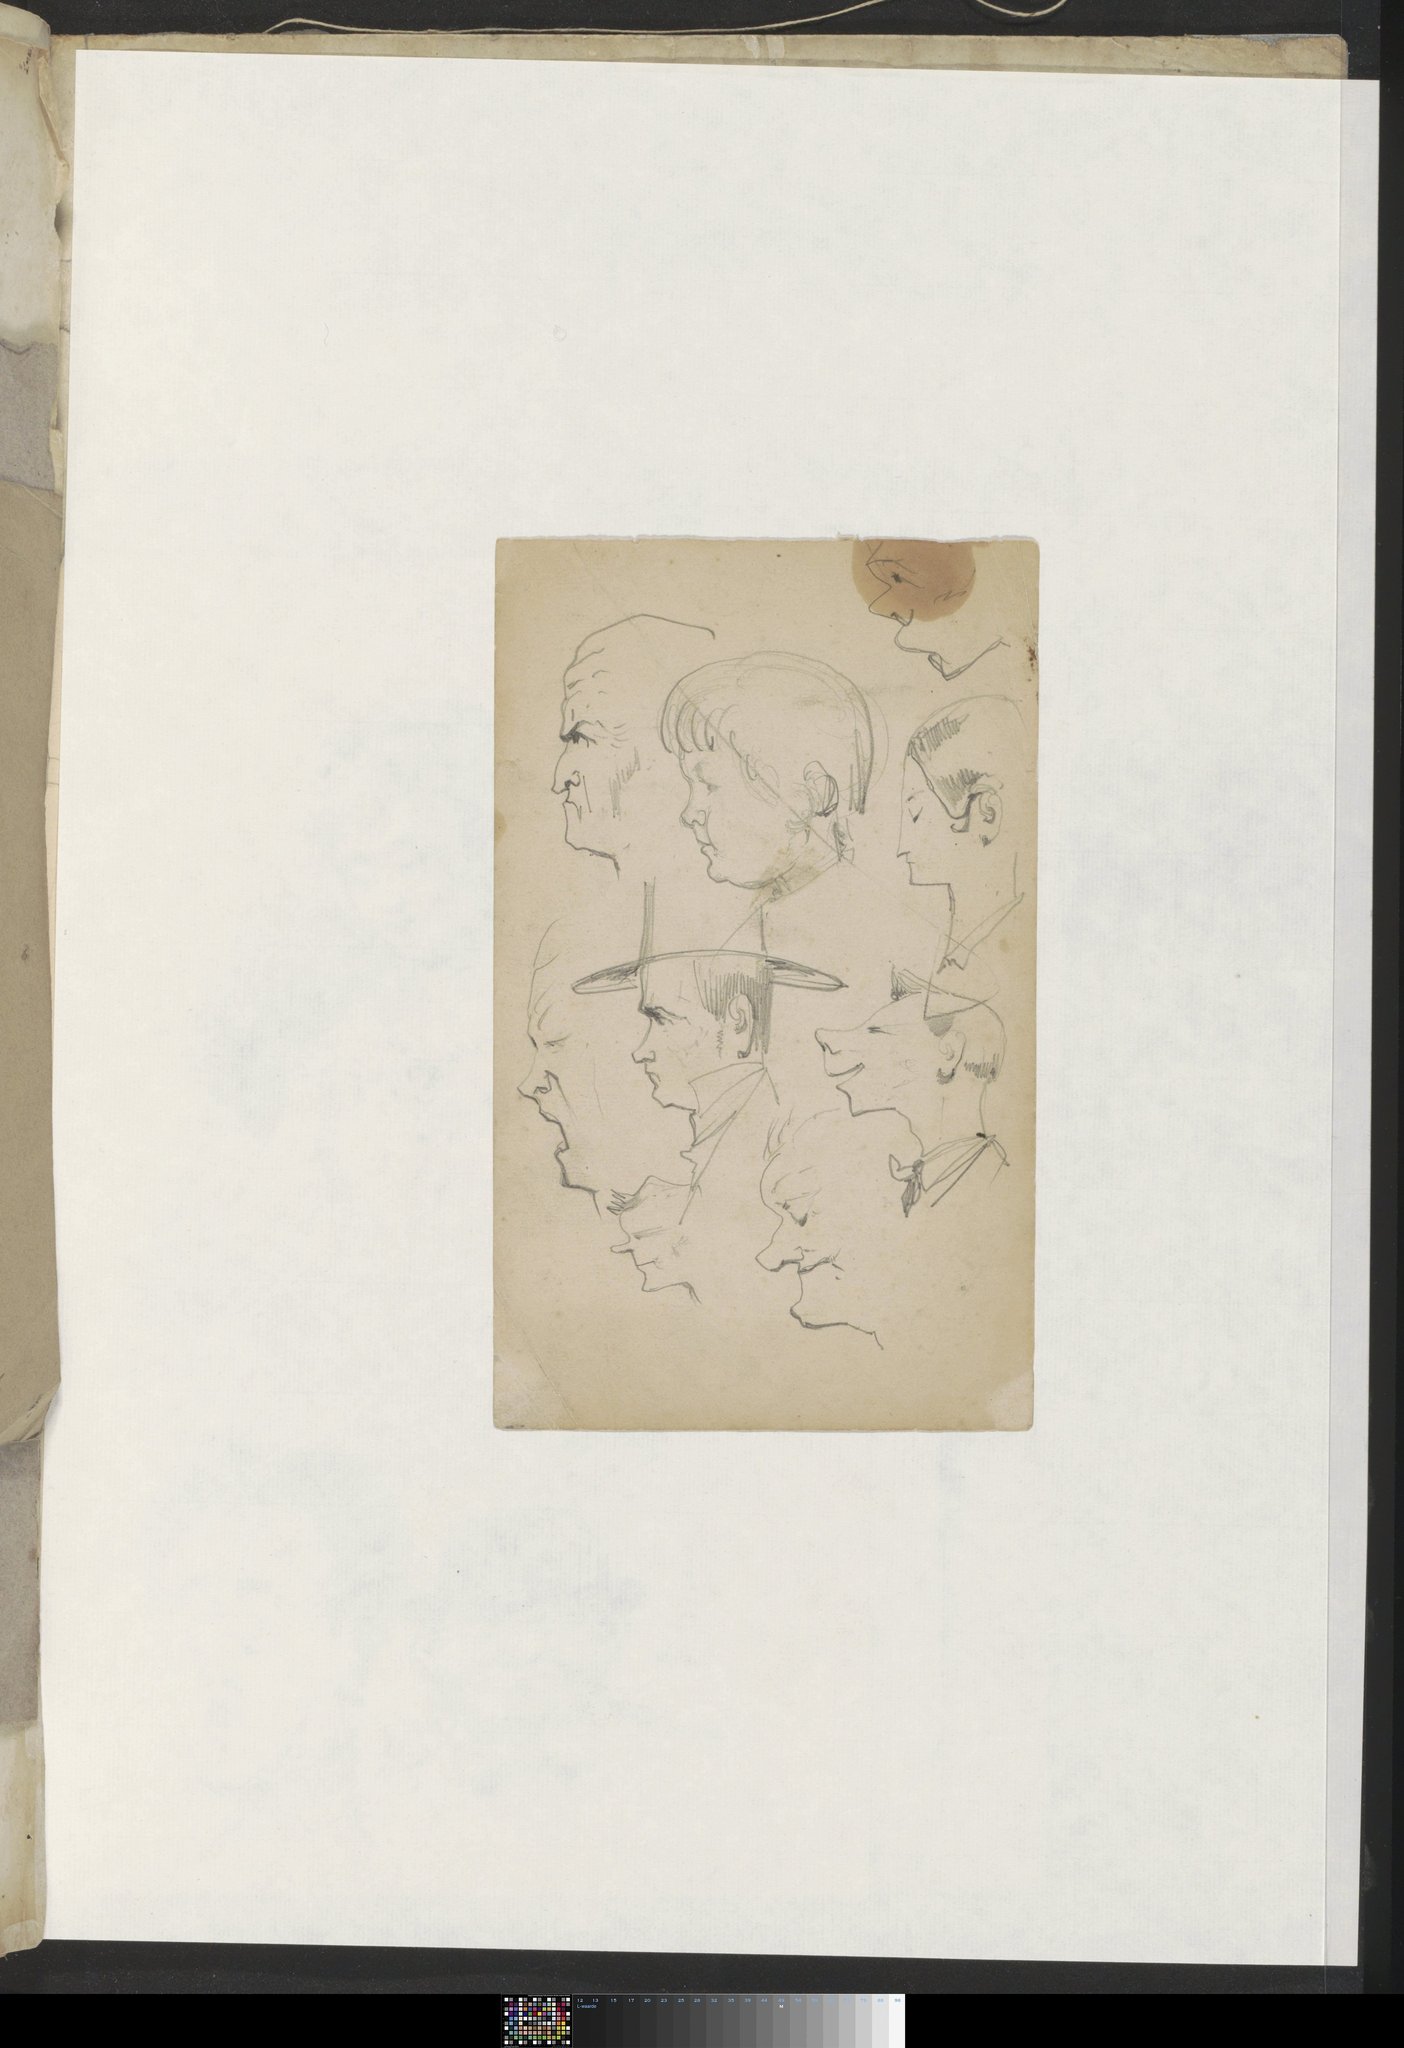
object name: sketchbook leaf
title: Studieblad met (karikaturale) koppen)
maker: johannes huybertus van hove bzn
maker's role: print maker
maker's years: 1827-1881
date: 1837-1881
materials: paper, pencil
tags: head (human)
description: Blad 37 recto, los blad in een schetsboek met 33 bladen en 10 losse tekeningen.